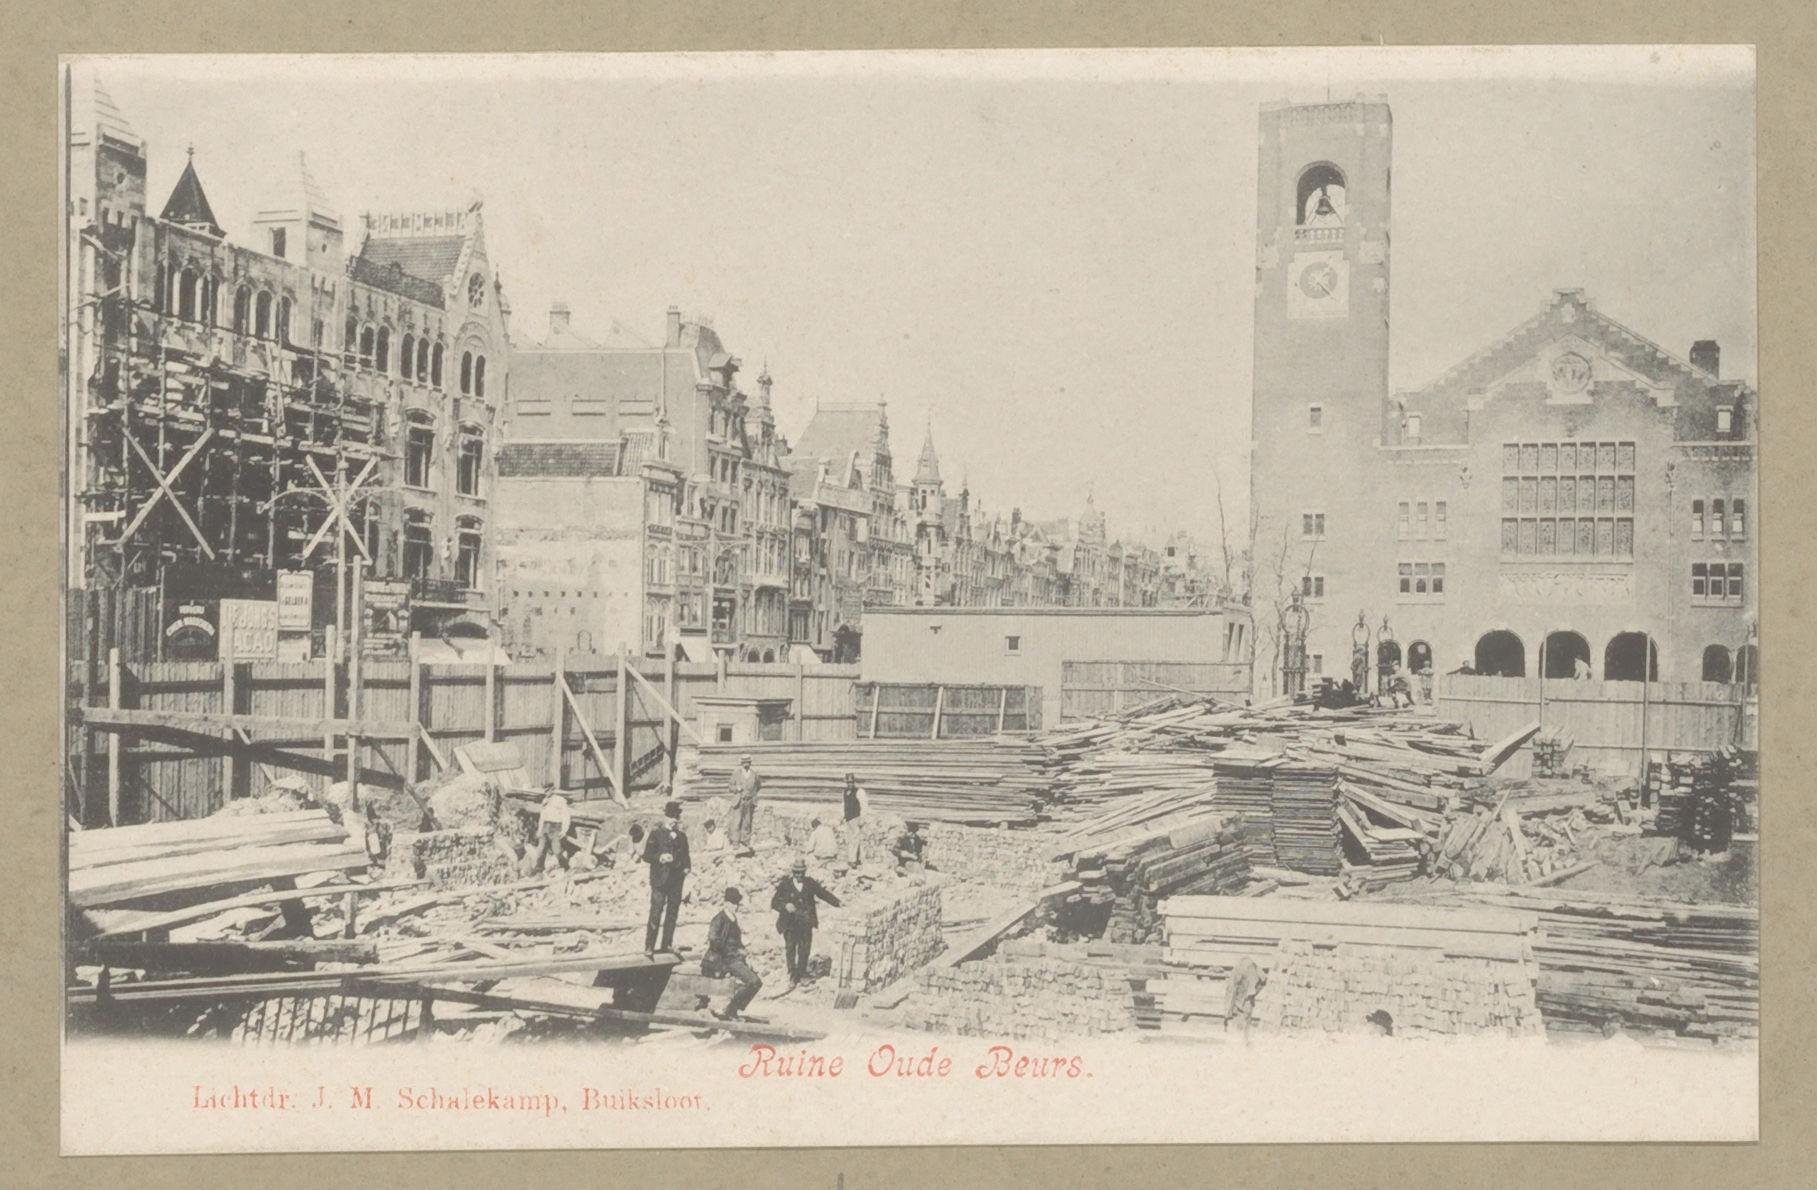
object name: ansichtkaart, prentbriefkaart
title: Ruine Oude Beurs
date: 1903-1905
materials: paper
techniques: photograph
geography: netherlands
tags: stock exchange, stock-market, demolition of building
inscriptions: collector's mark: Lugt 1641b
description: Onderwerpsrubriek binnen de Atlas Amsterdam: Handel en Zeevaart: Hulpbeurs op de Dam en Beurs (Dam).